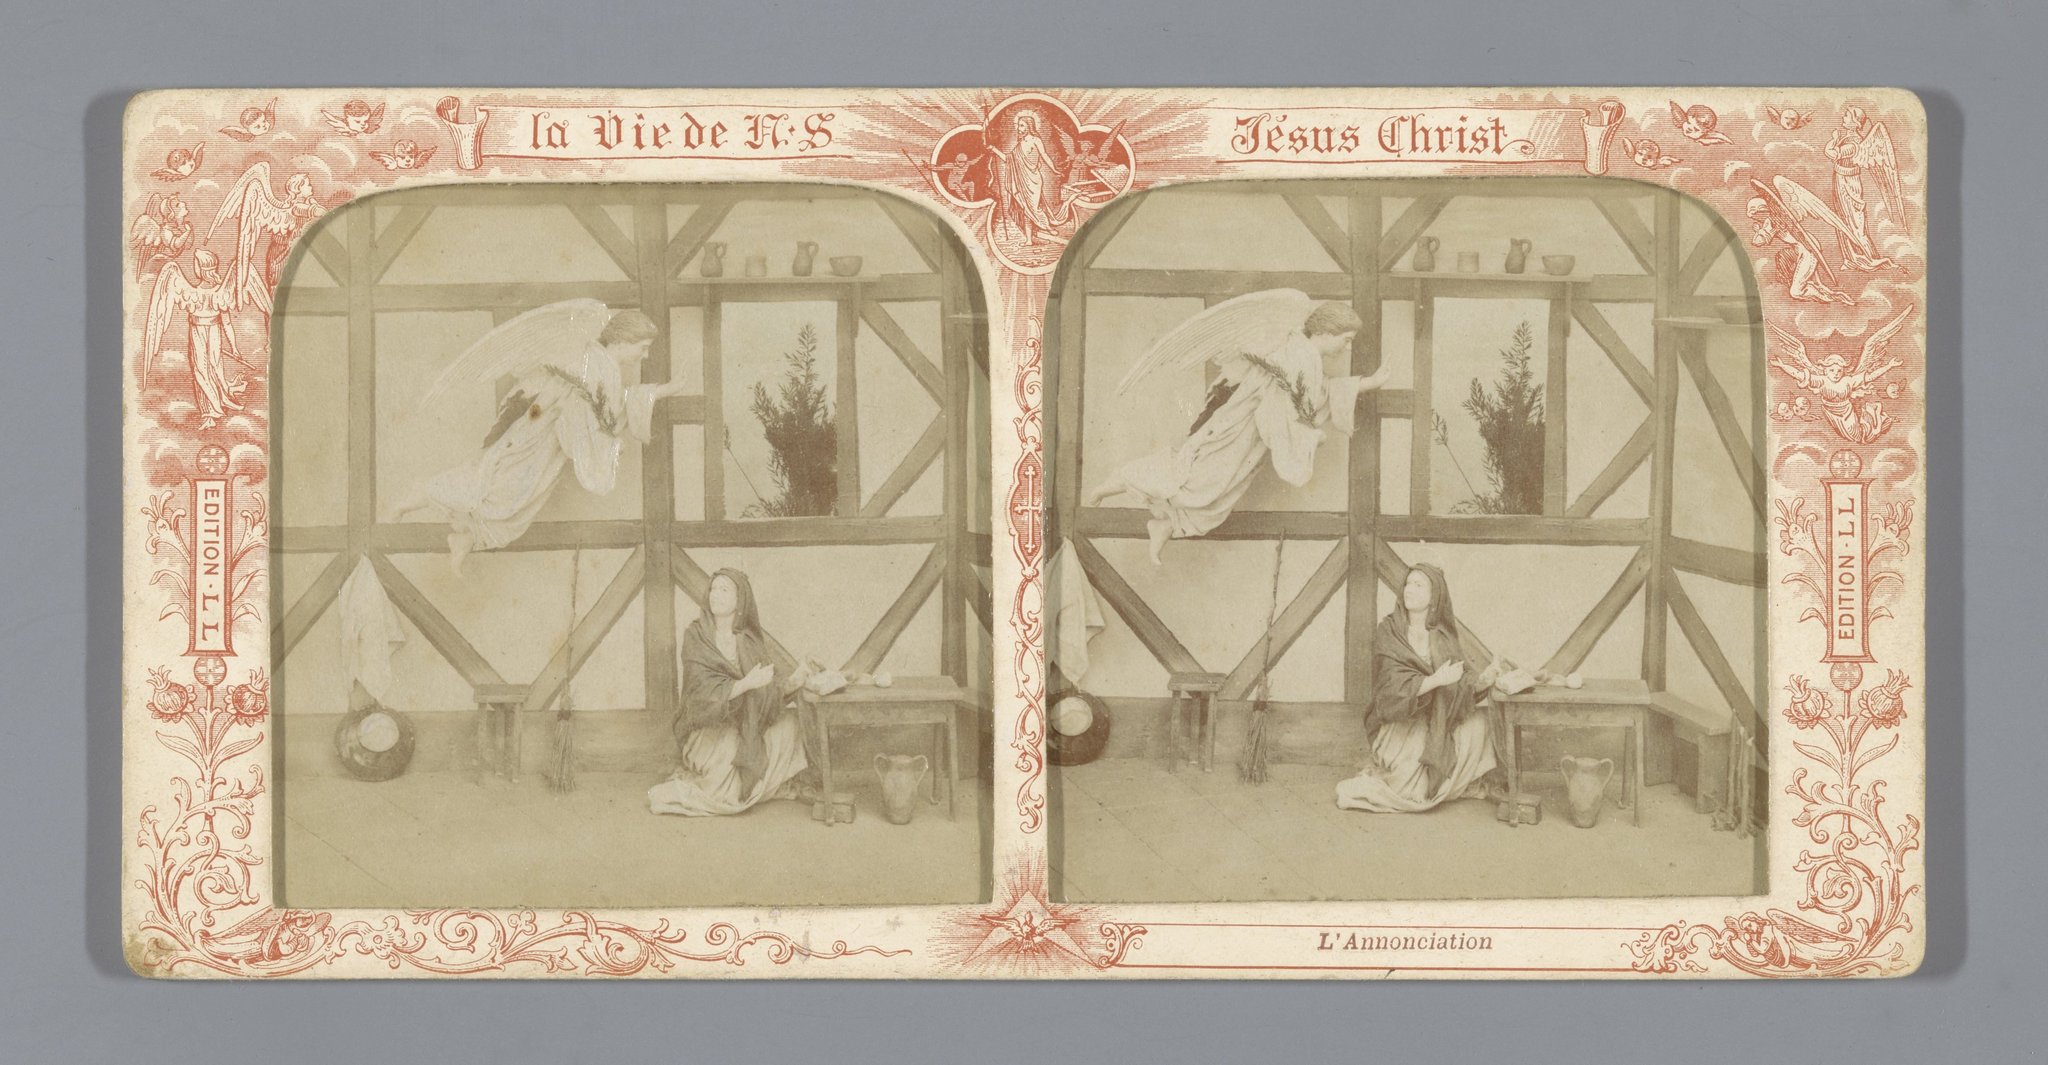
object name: tissue stereograph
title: L'Annonciation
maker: Anonymous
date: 1864-1905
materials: cardboard, paper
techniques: albumen print, hand coloring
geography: paris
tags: the annunciation: mary sitting